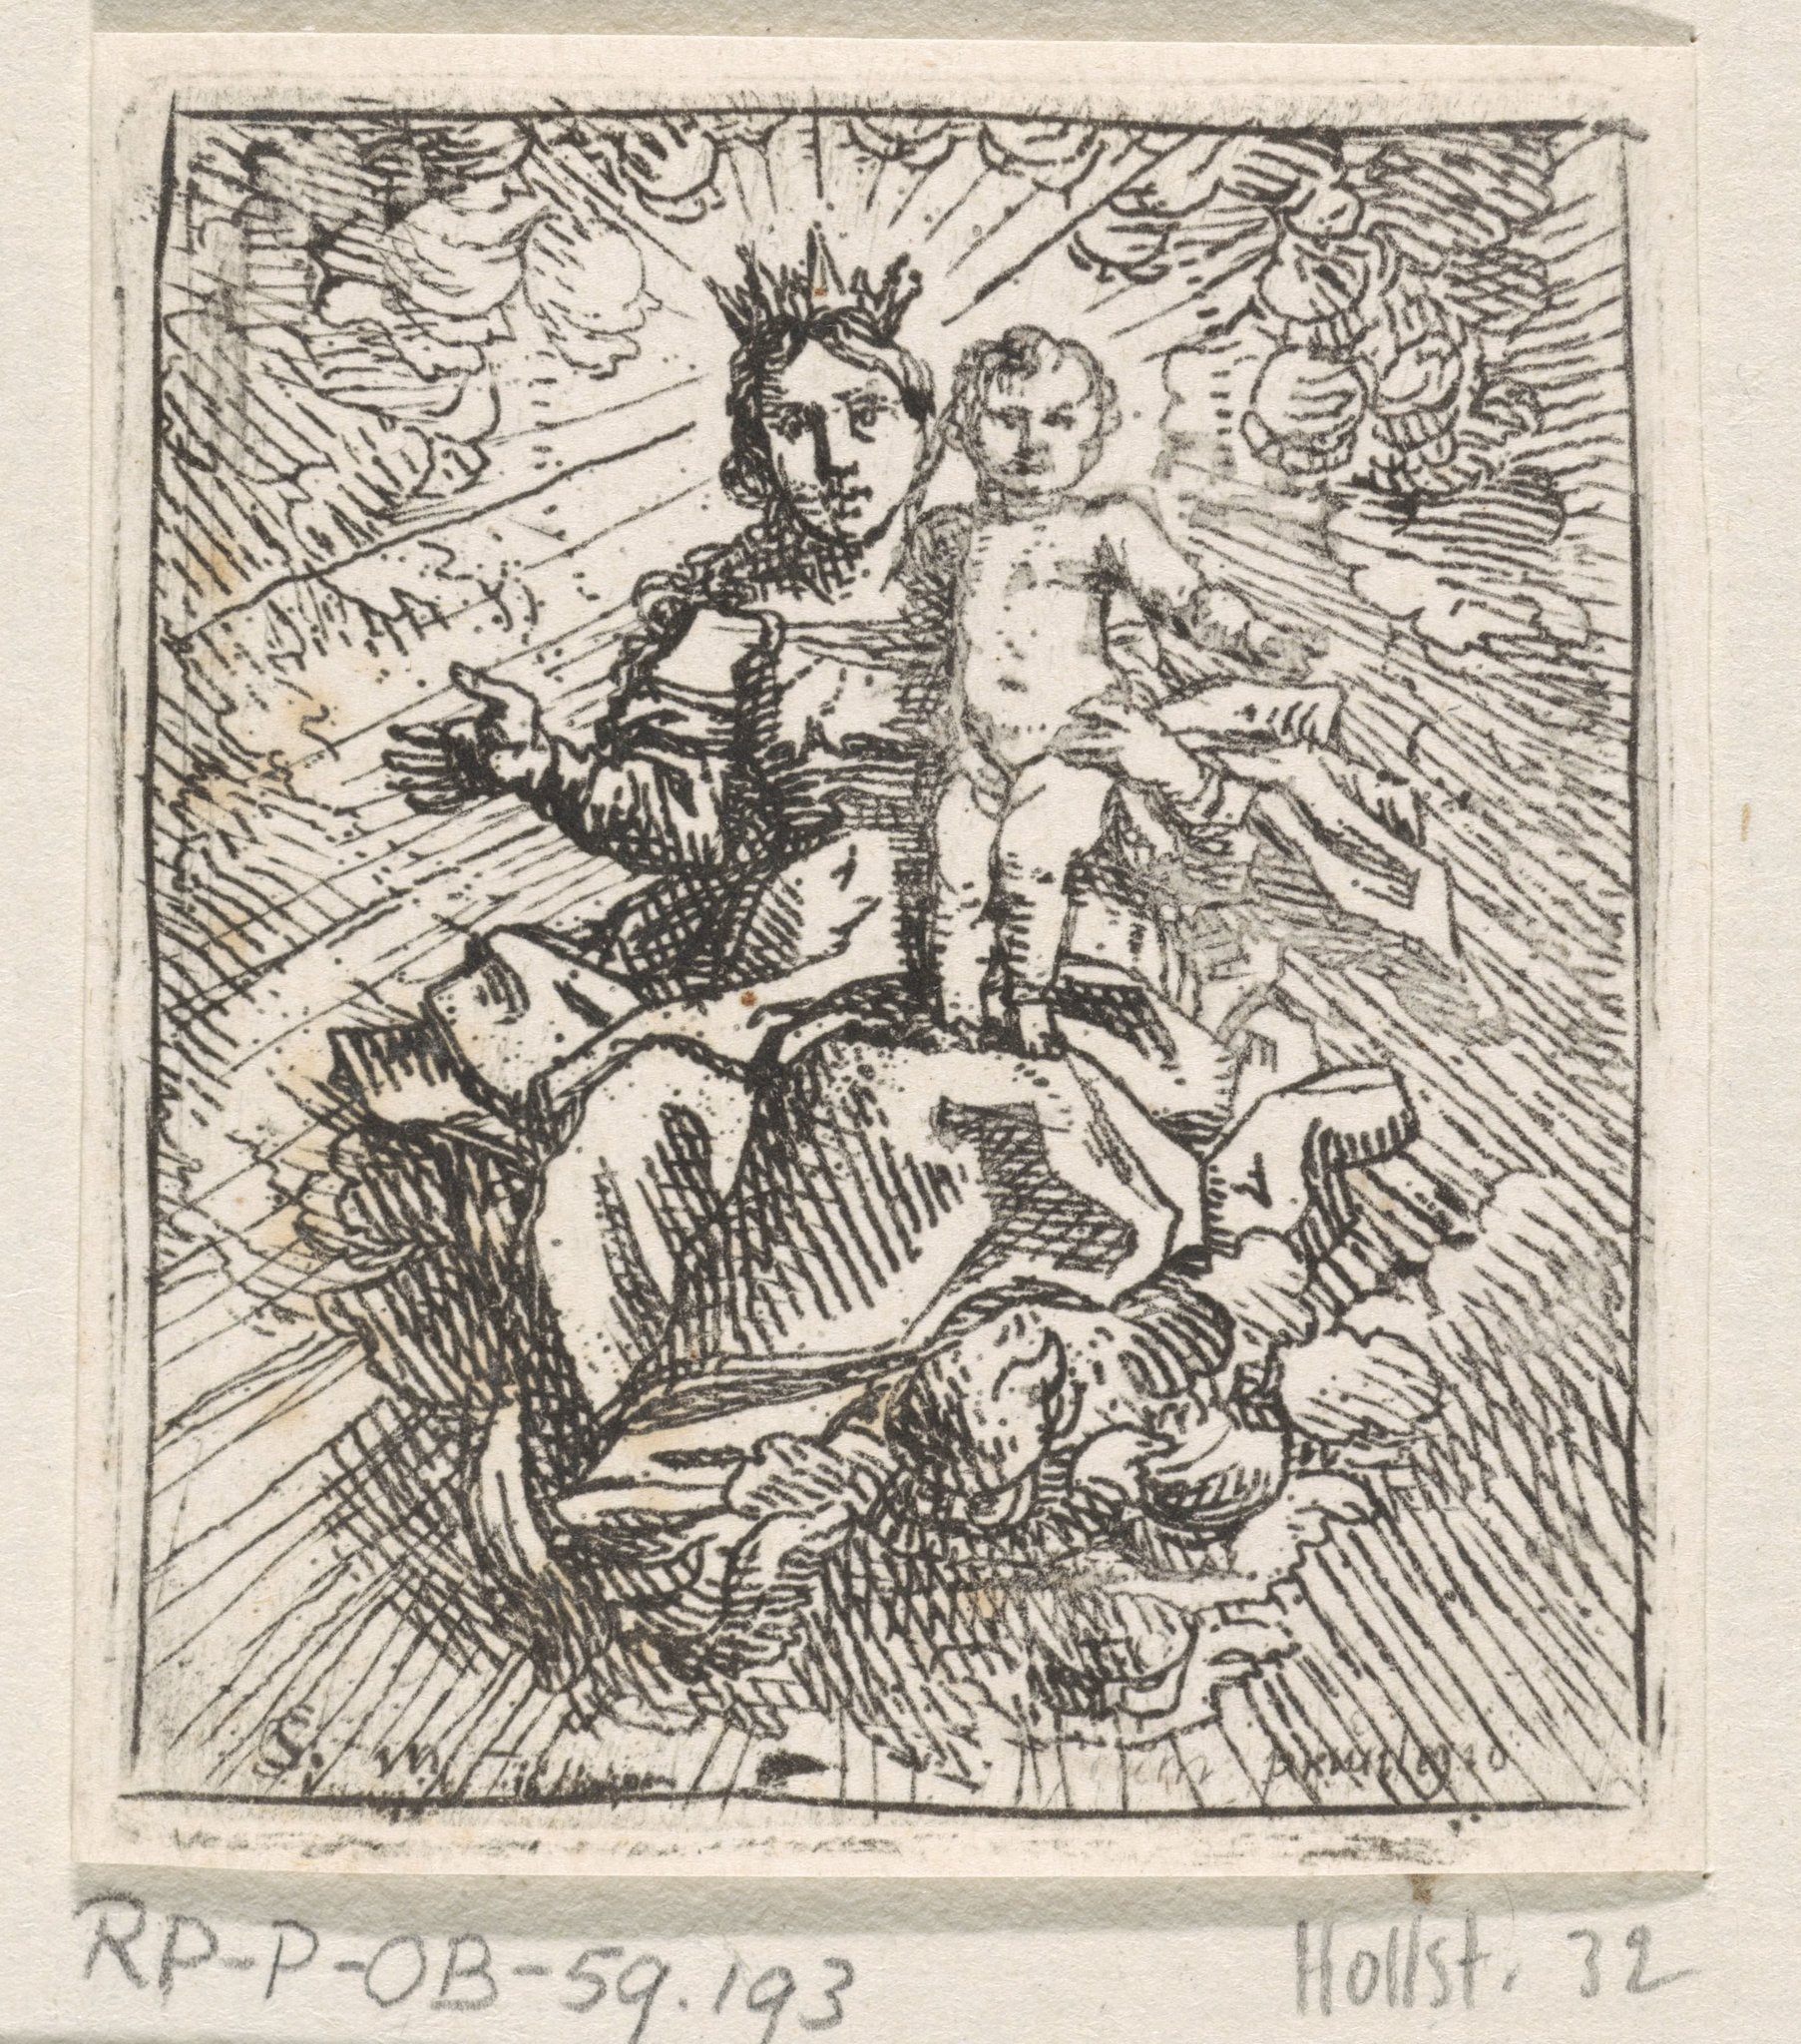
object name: print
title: Madonna met Christuskind in de wolken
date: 1618-1655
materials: paper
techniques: etching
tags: madonna (i.e. mary with the christ-child) in the air, or on the clouds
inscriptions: collector's mark: Lugt 240